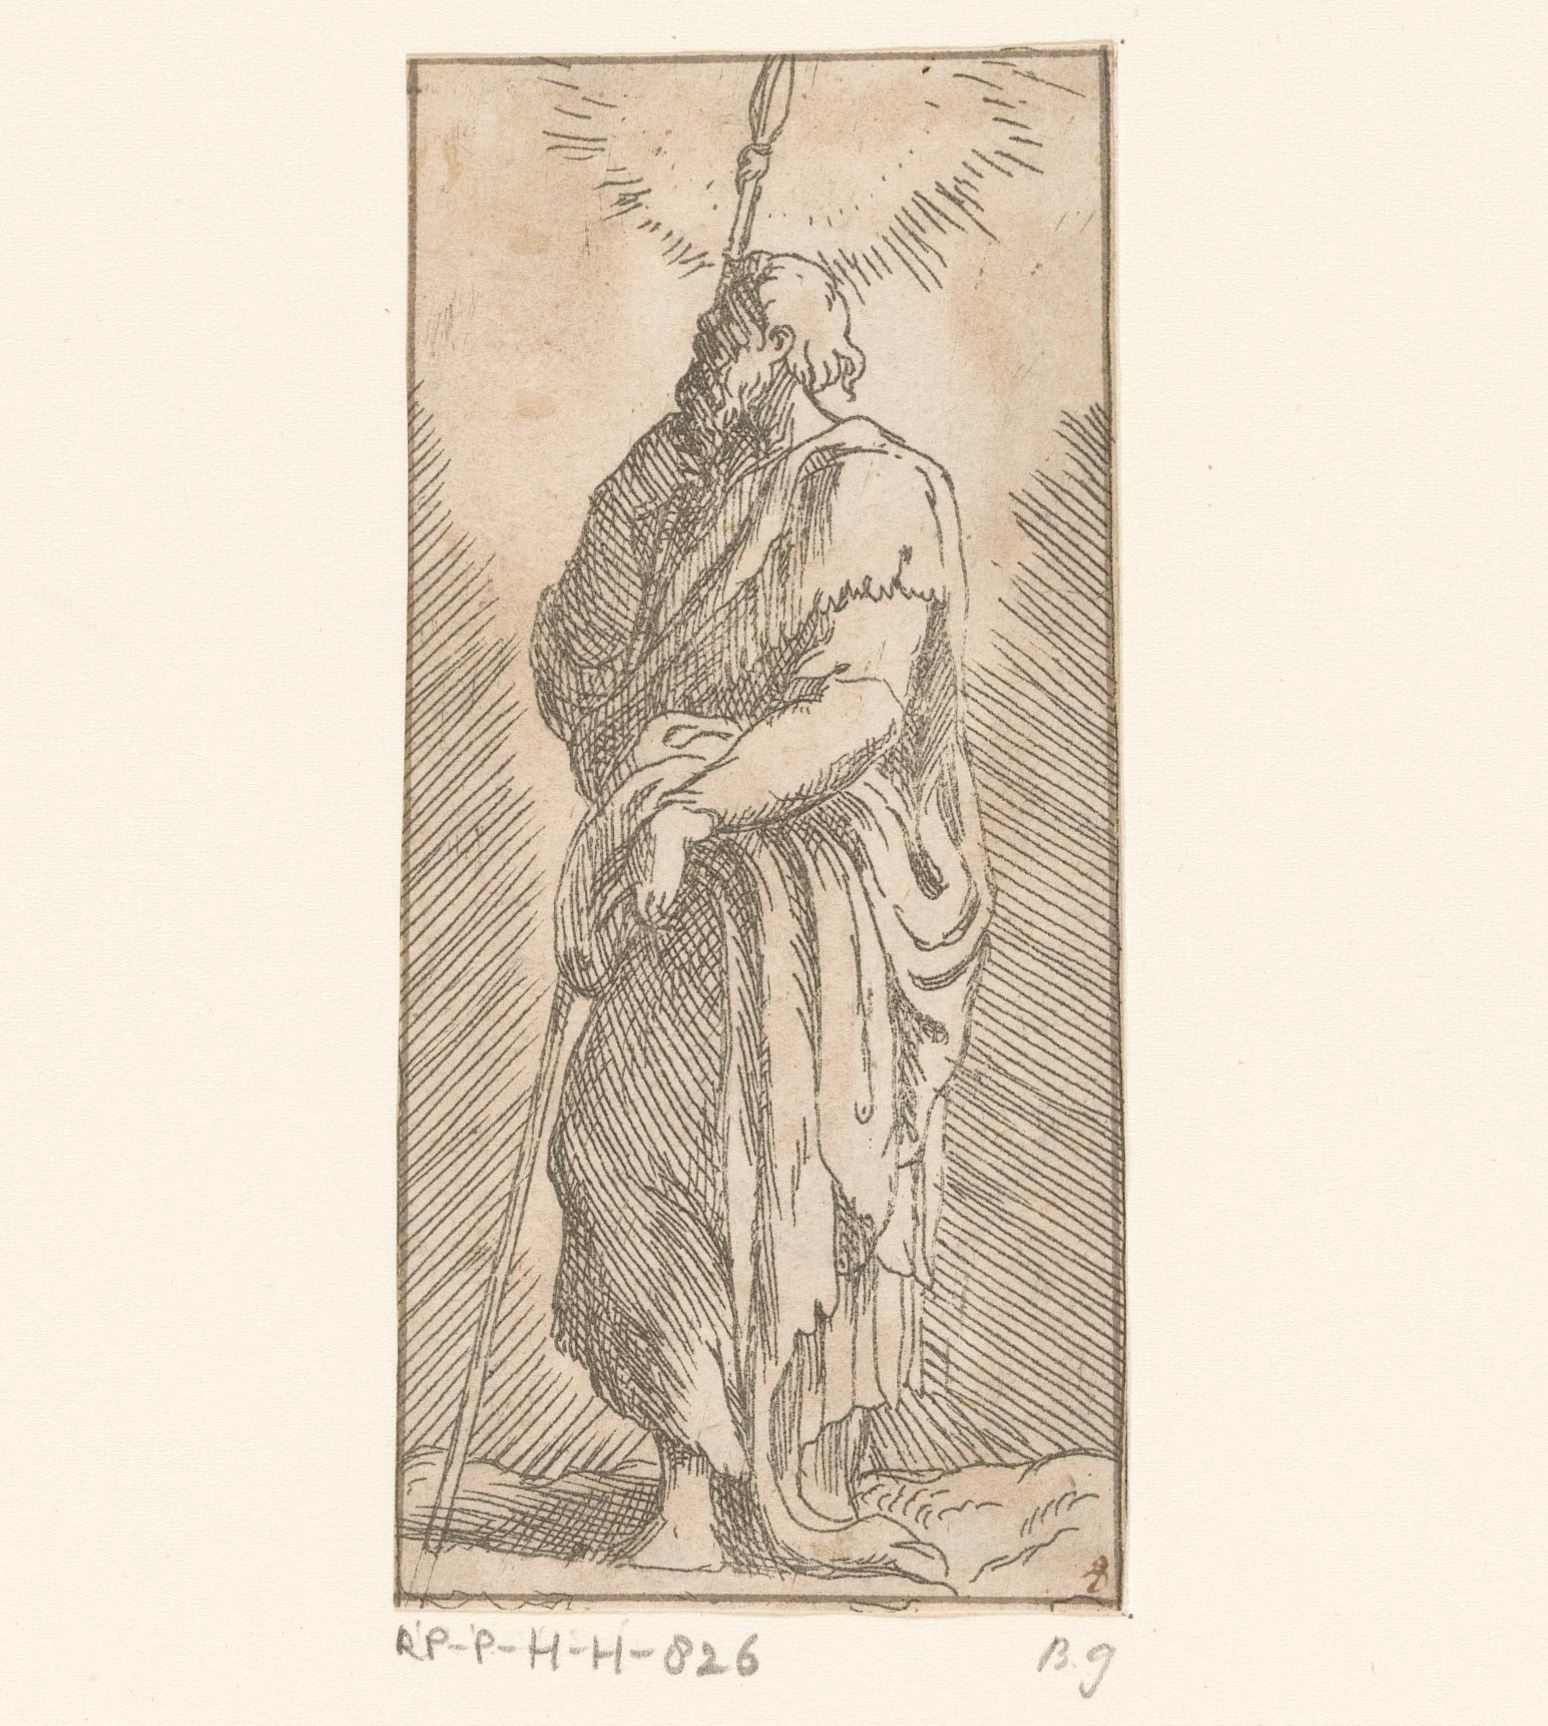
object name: print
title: Christus en de apostelen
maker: monogrammist fp (italië; 16e eeuw)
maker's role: print maker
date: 1500-1599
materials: paper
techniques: etching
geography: italy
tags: the apostle thomas; possible attributes: book, chalice, girdle, heart, lance or spear, scroll, square, stones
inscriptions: collector's mark: Lugt 10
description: Deze prent maakt deel uit van een reeks van dertien prenten van Christus en de twaalf apostelen. Onderkant prent met monogram is afgesneden.